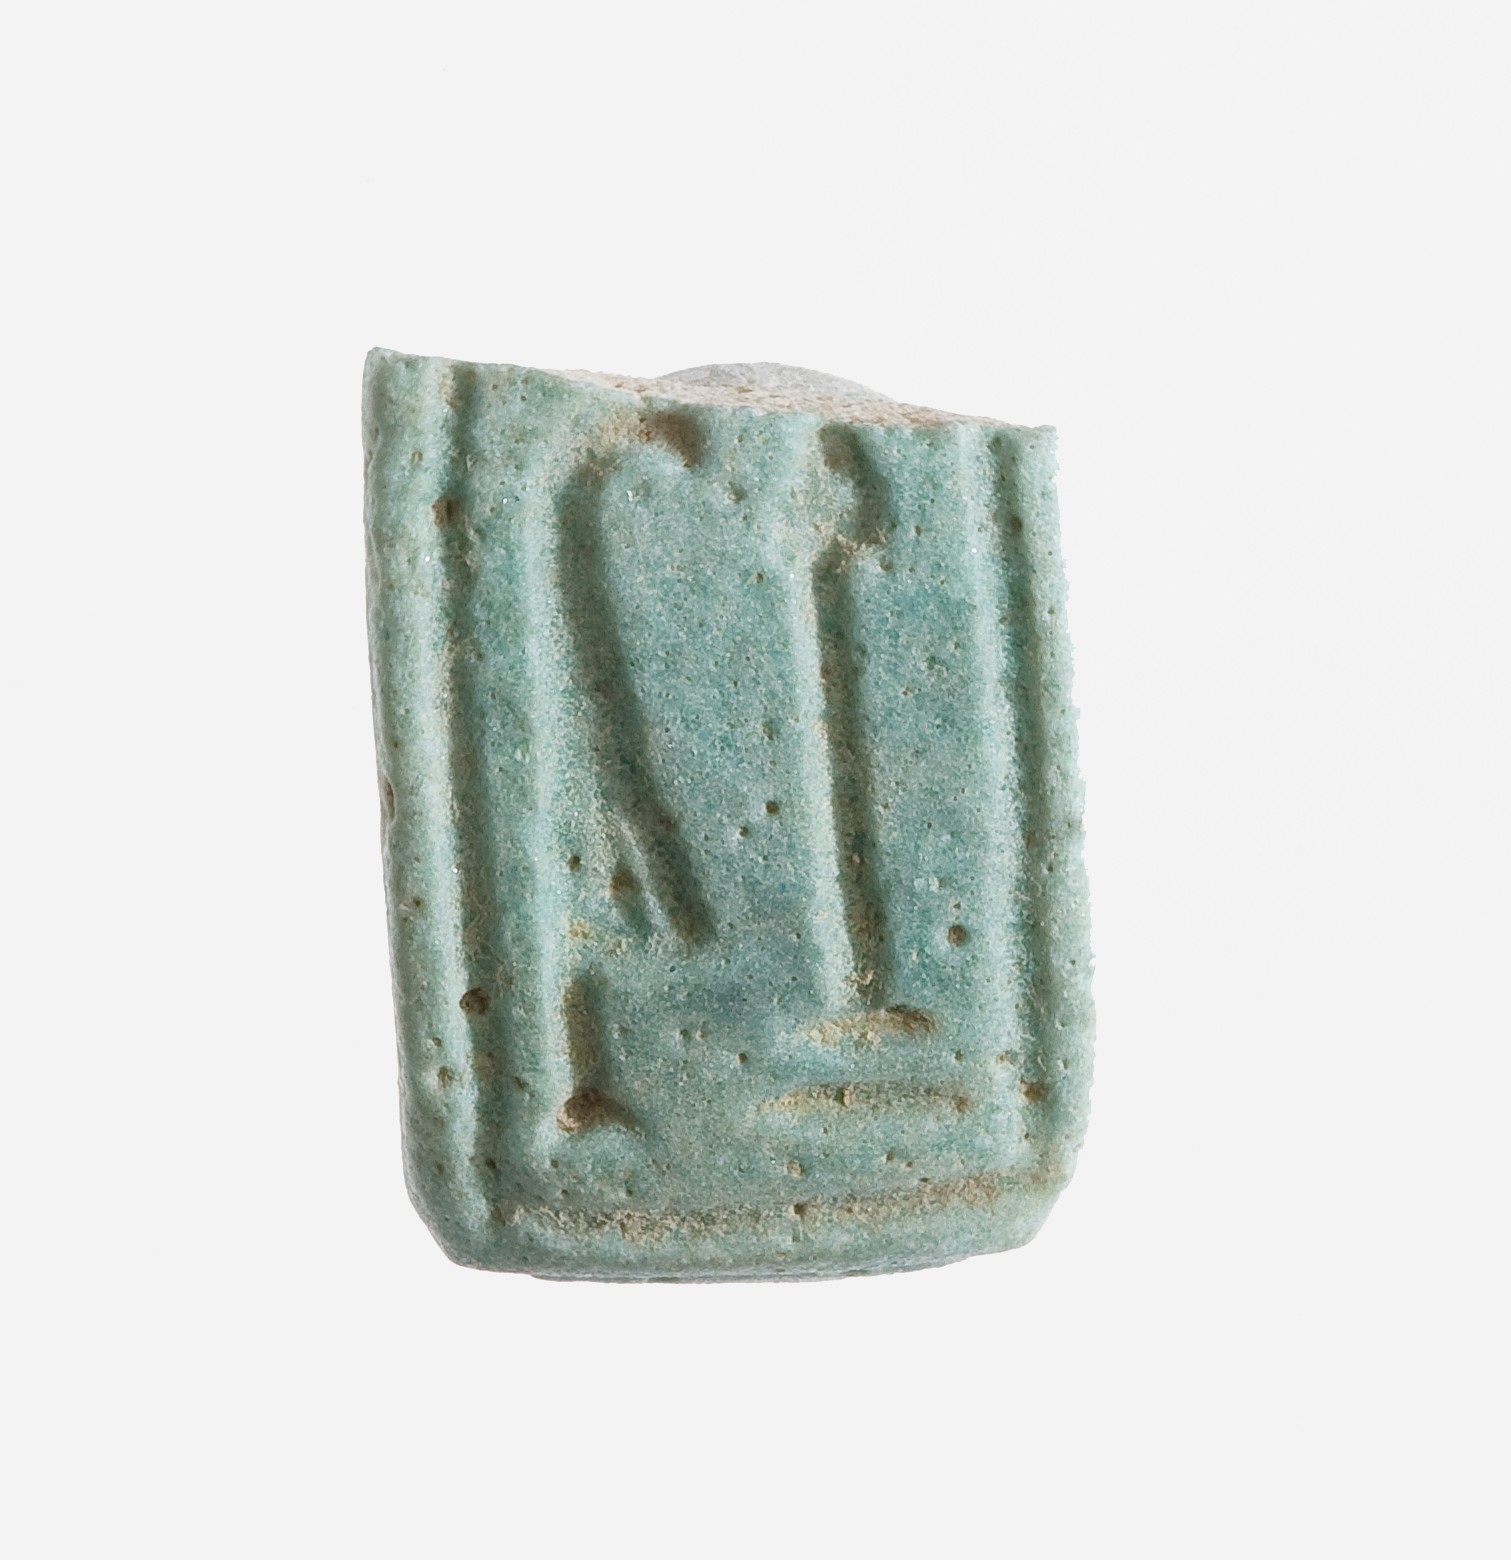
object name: ring fragment, maat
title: Ring Fragment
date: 1390-1352 BCE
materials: faience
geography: egypt